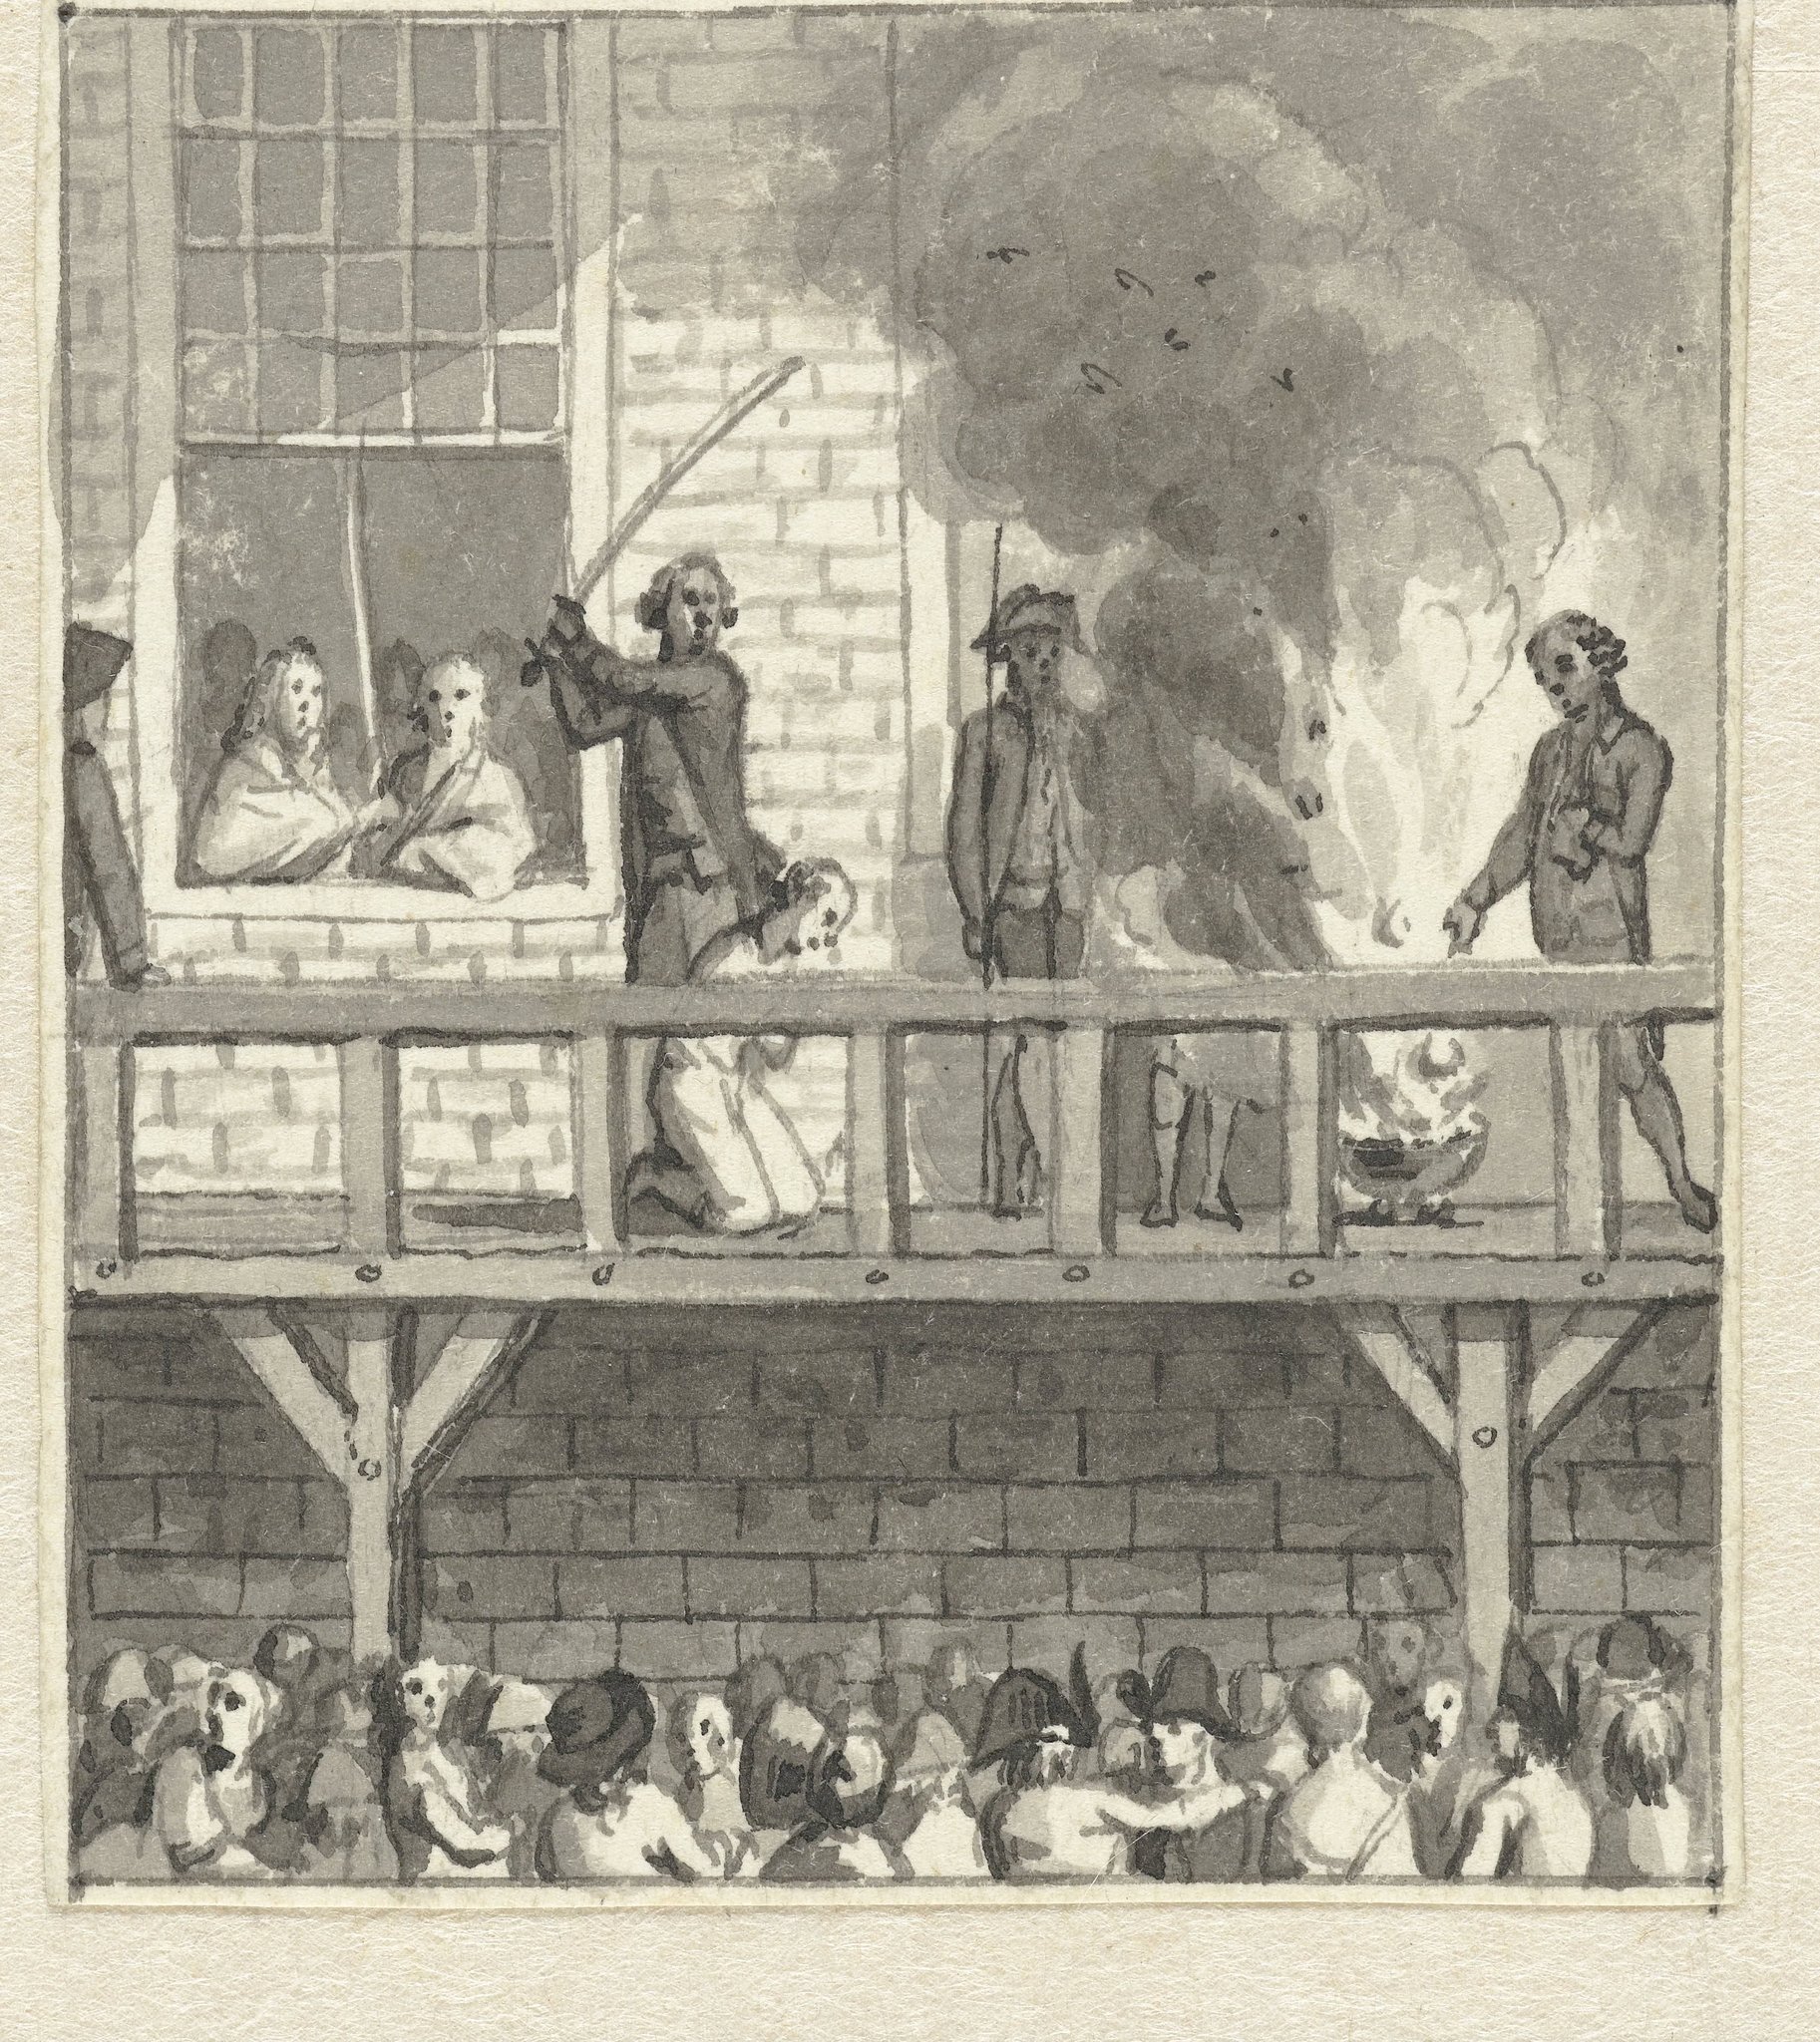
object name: design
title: In 't Jaar 1789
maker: Anonymous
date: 1789-1810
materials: ink, paper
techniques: brush, pen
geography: netherlands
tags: burning of books, patriots (1780-1795)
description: Het verbranden van pamfletten van uitgeweken patriotten op een schavot voor het stadhuis op de Dam te Amsterdam, 24 januari 1789. Tegelijkertijd werd de verspreider van de pamfletten in het openbaar gegeseld (niet onthoofd).